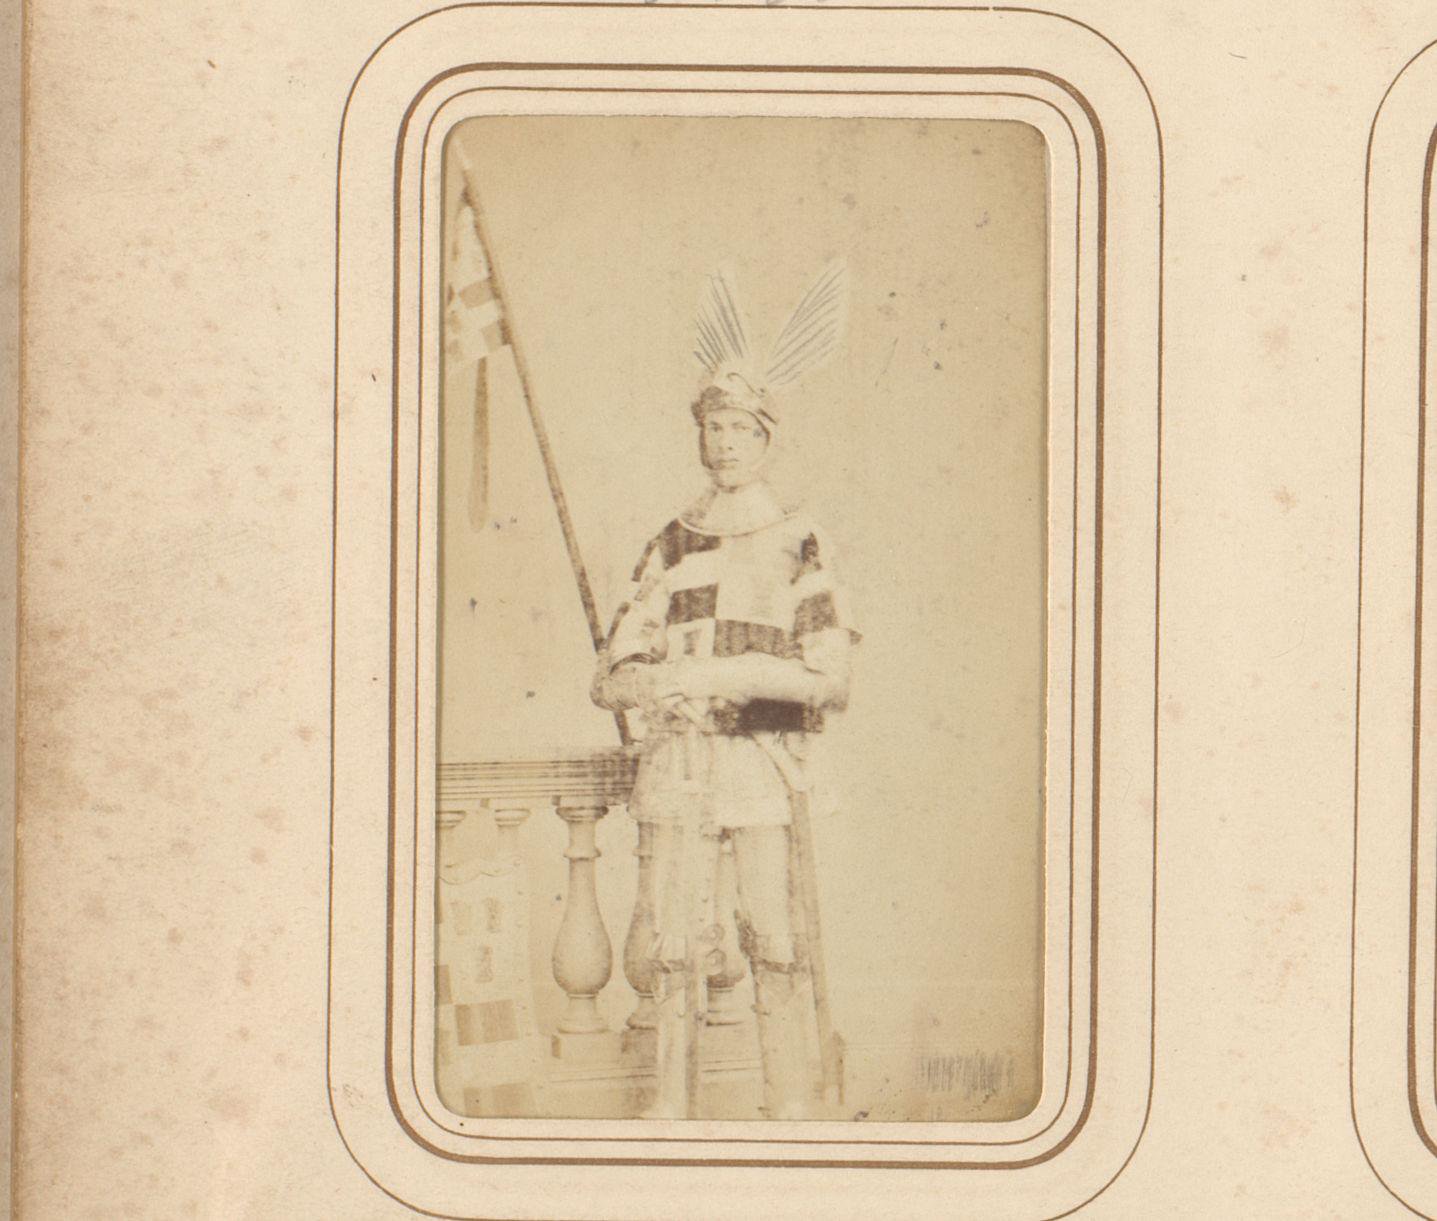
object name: carte de visite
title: Portret van een jonge man in kostuum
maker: henri pronk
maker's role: fotograaf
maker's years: 1813-1893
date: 1865-1885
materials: cardboard, photographic support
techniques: albumen print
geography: utrecht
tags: stage costume, youth, adolescent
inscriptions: inscription: ‘Henri Pronk/ Photographe /Utrecht’, inscription: ‘H. Pronk, Photo.’